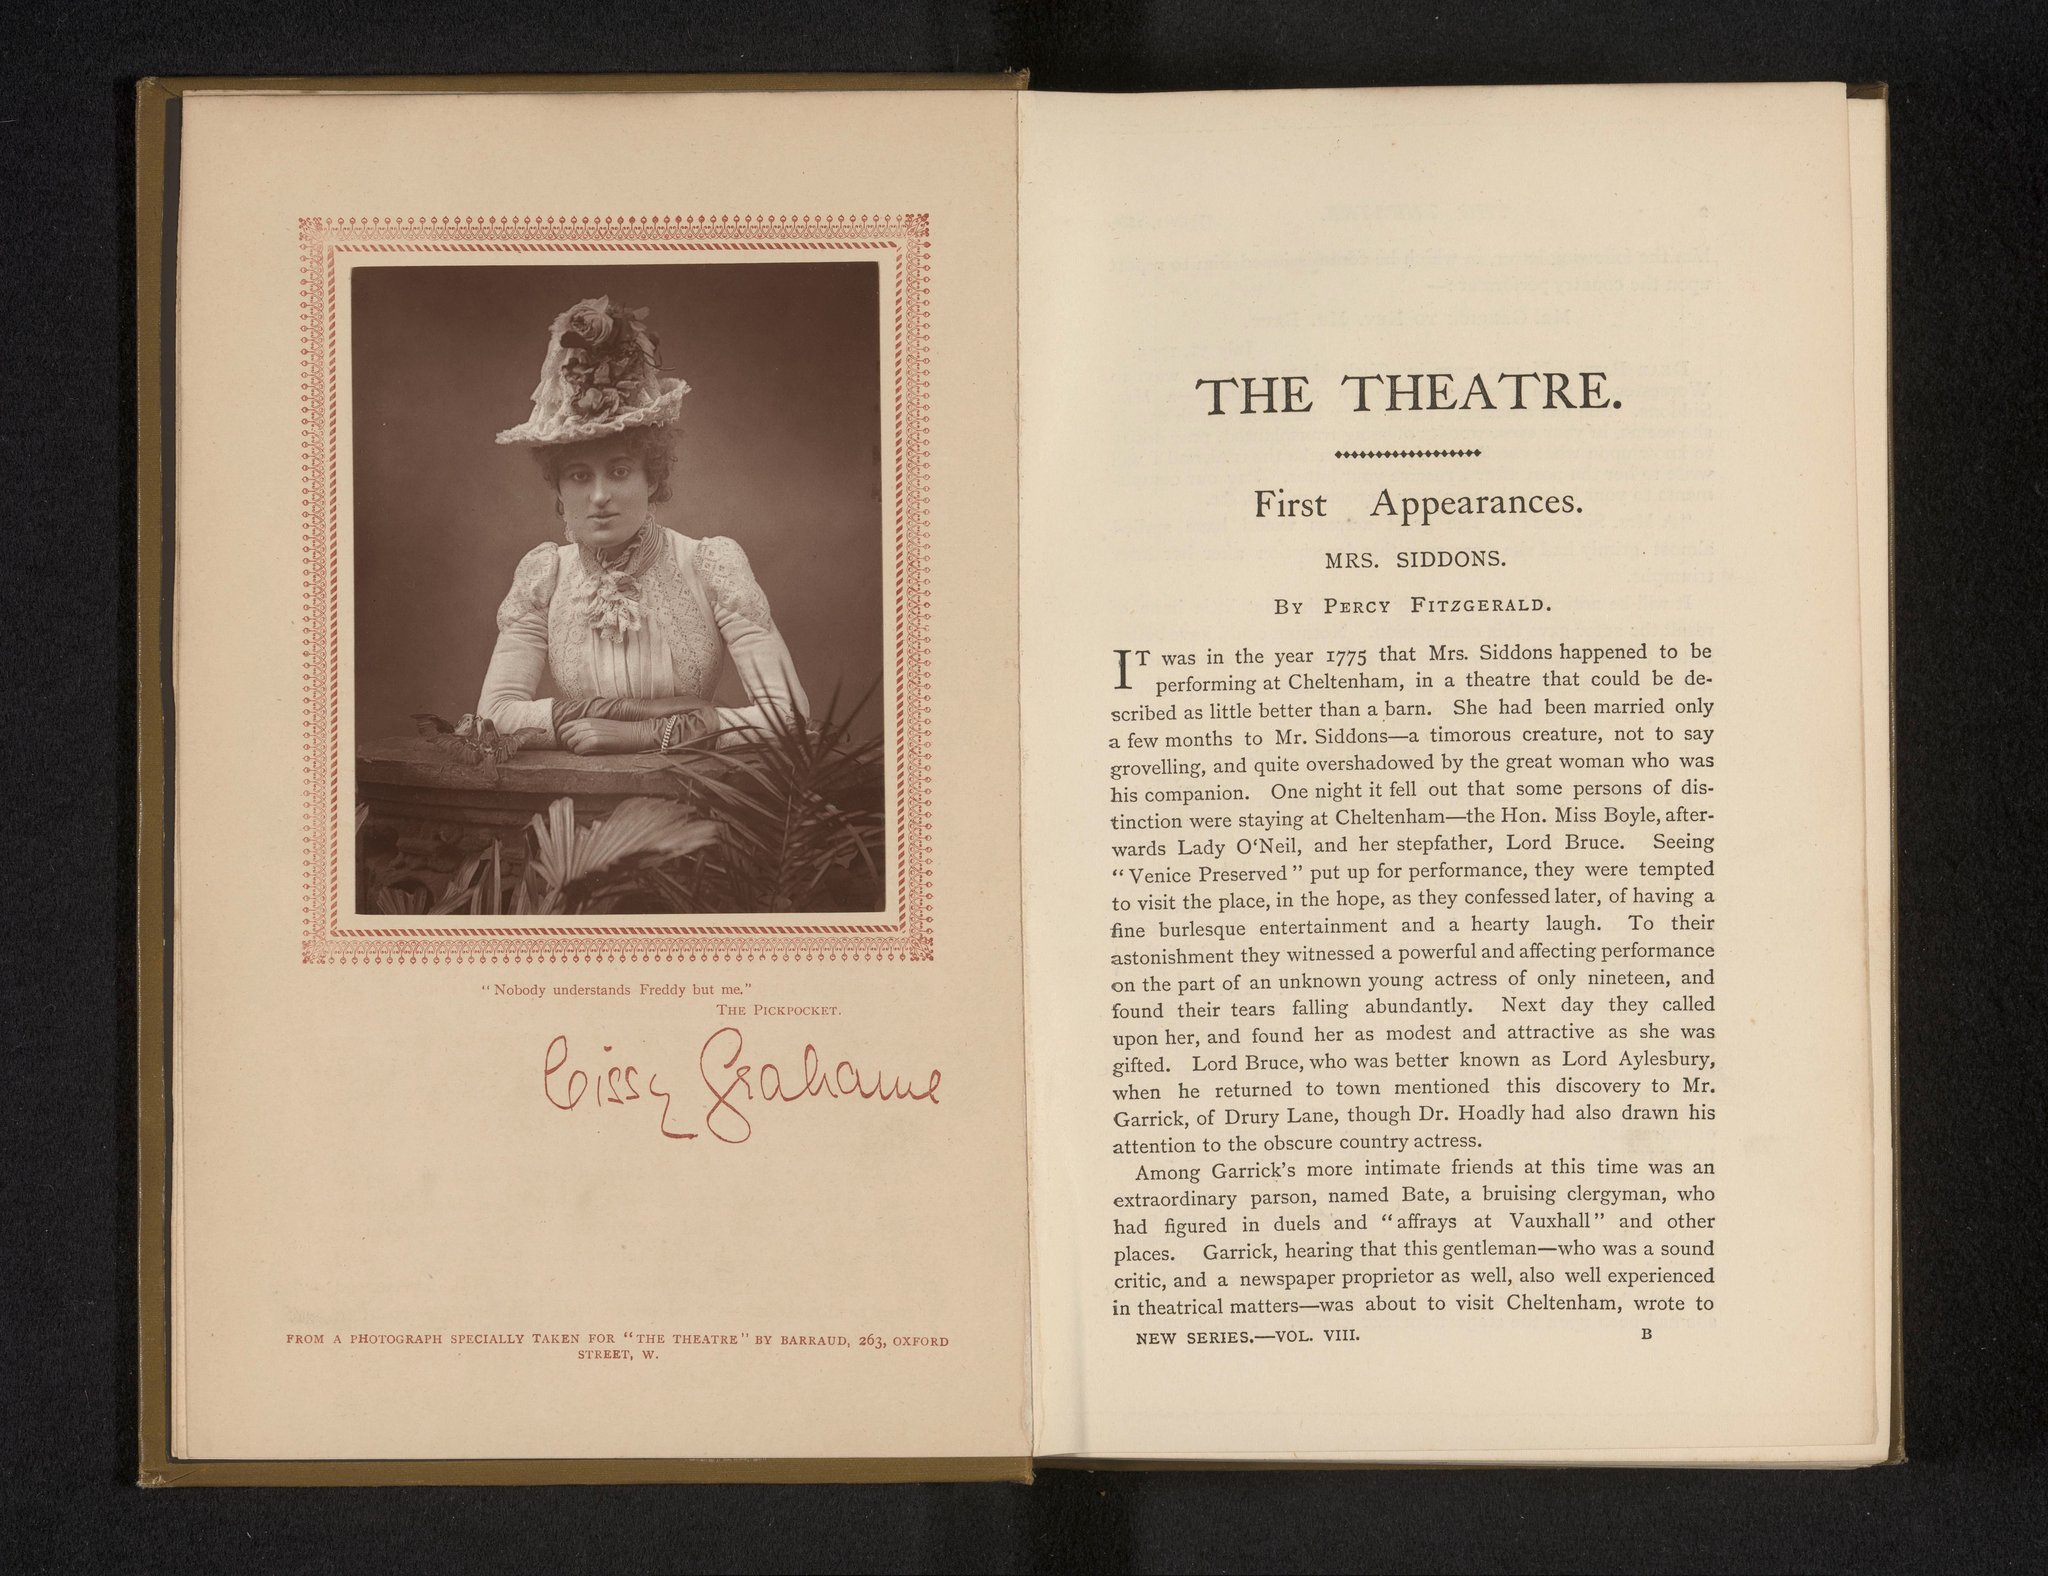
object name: page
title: Portret van Cissy Grahame in 'The Pick Pocket'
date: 1881-1886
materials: paper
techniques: woodburytype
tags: adult woman, historical persons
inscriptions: signature: ‘Cissy Grahame’, inscription: ‘'Nobody understands Freddy but me.'/ The Pickpocket’